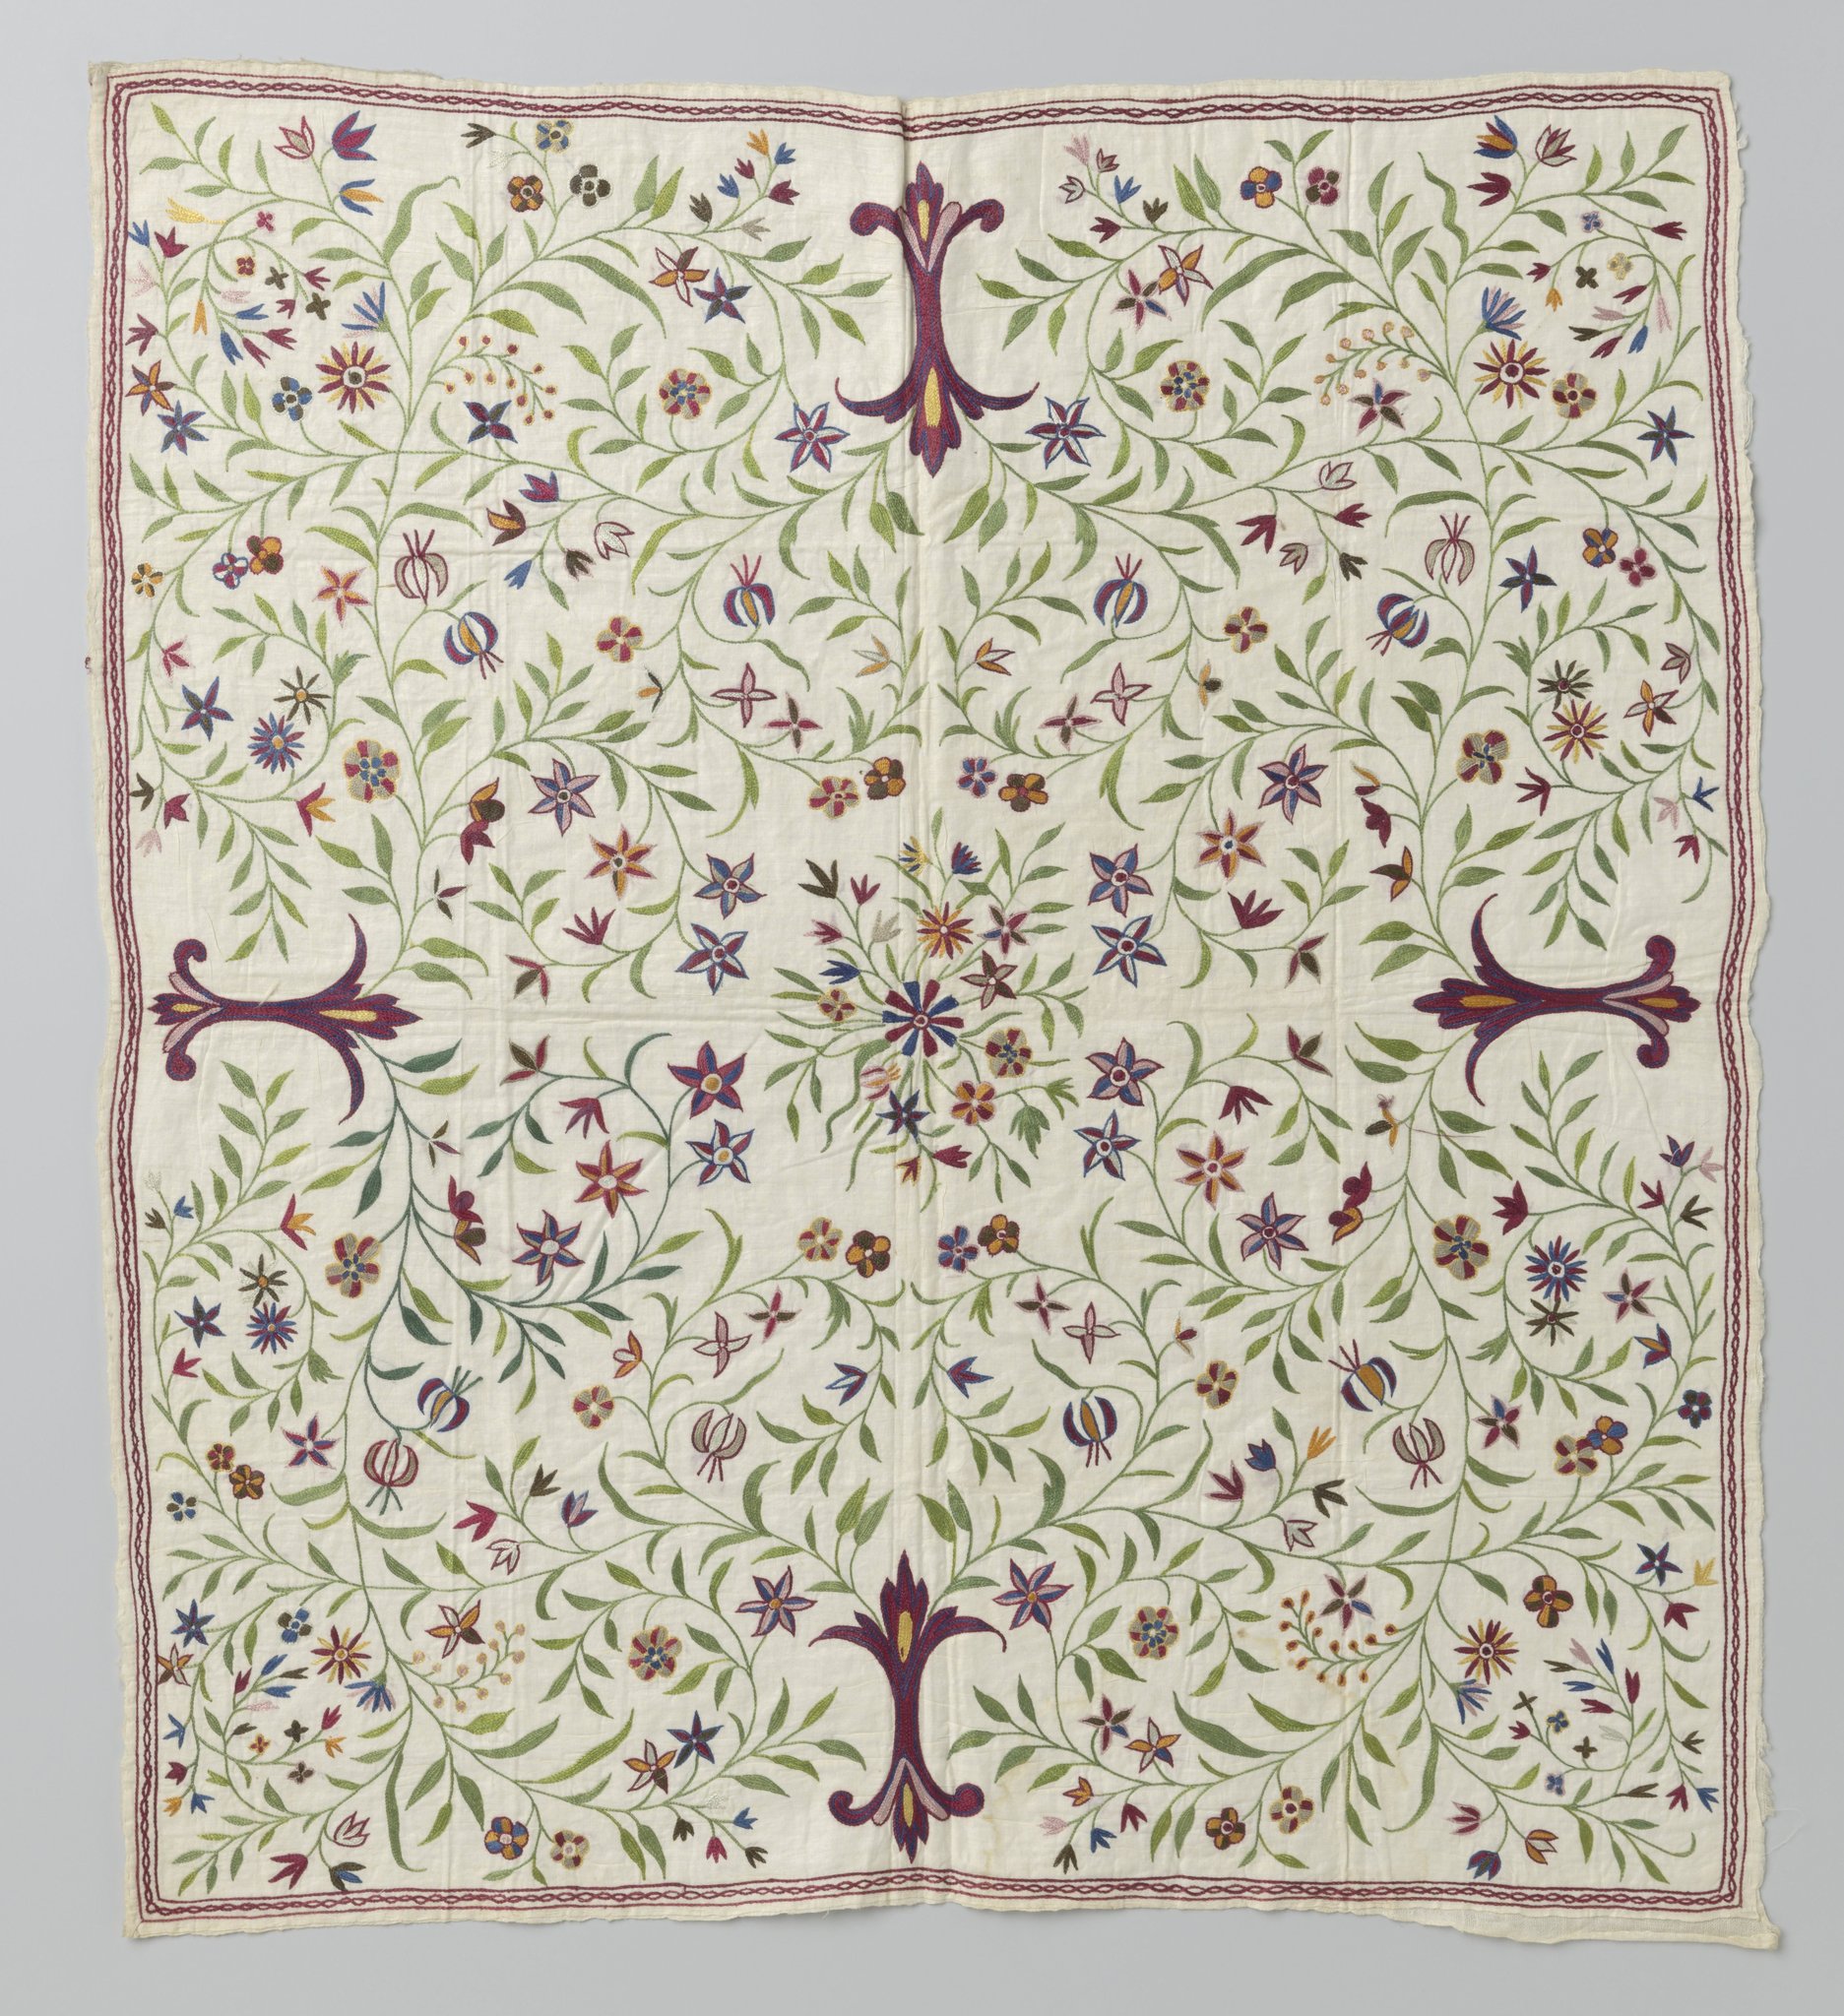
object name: textile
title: Kleed oosterse textiel met veelkleurig borduurwerk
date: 1800-1899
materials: cotton, silk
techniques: embroidered, weave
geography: east indies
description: Kleed van veelkleurig getamboereerde katoen, versierd met bloemranken en ornament, gevoerd met katoen.